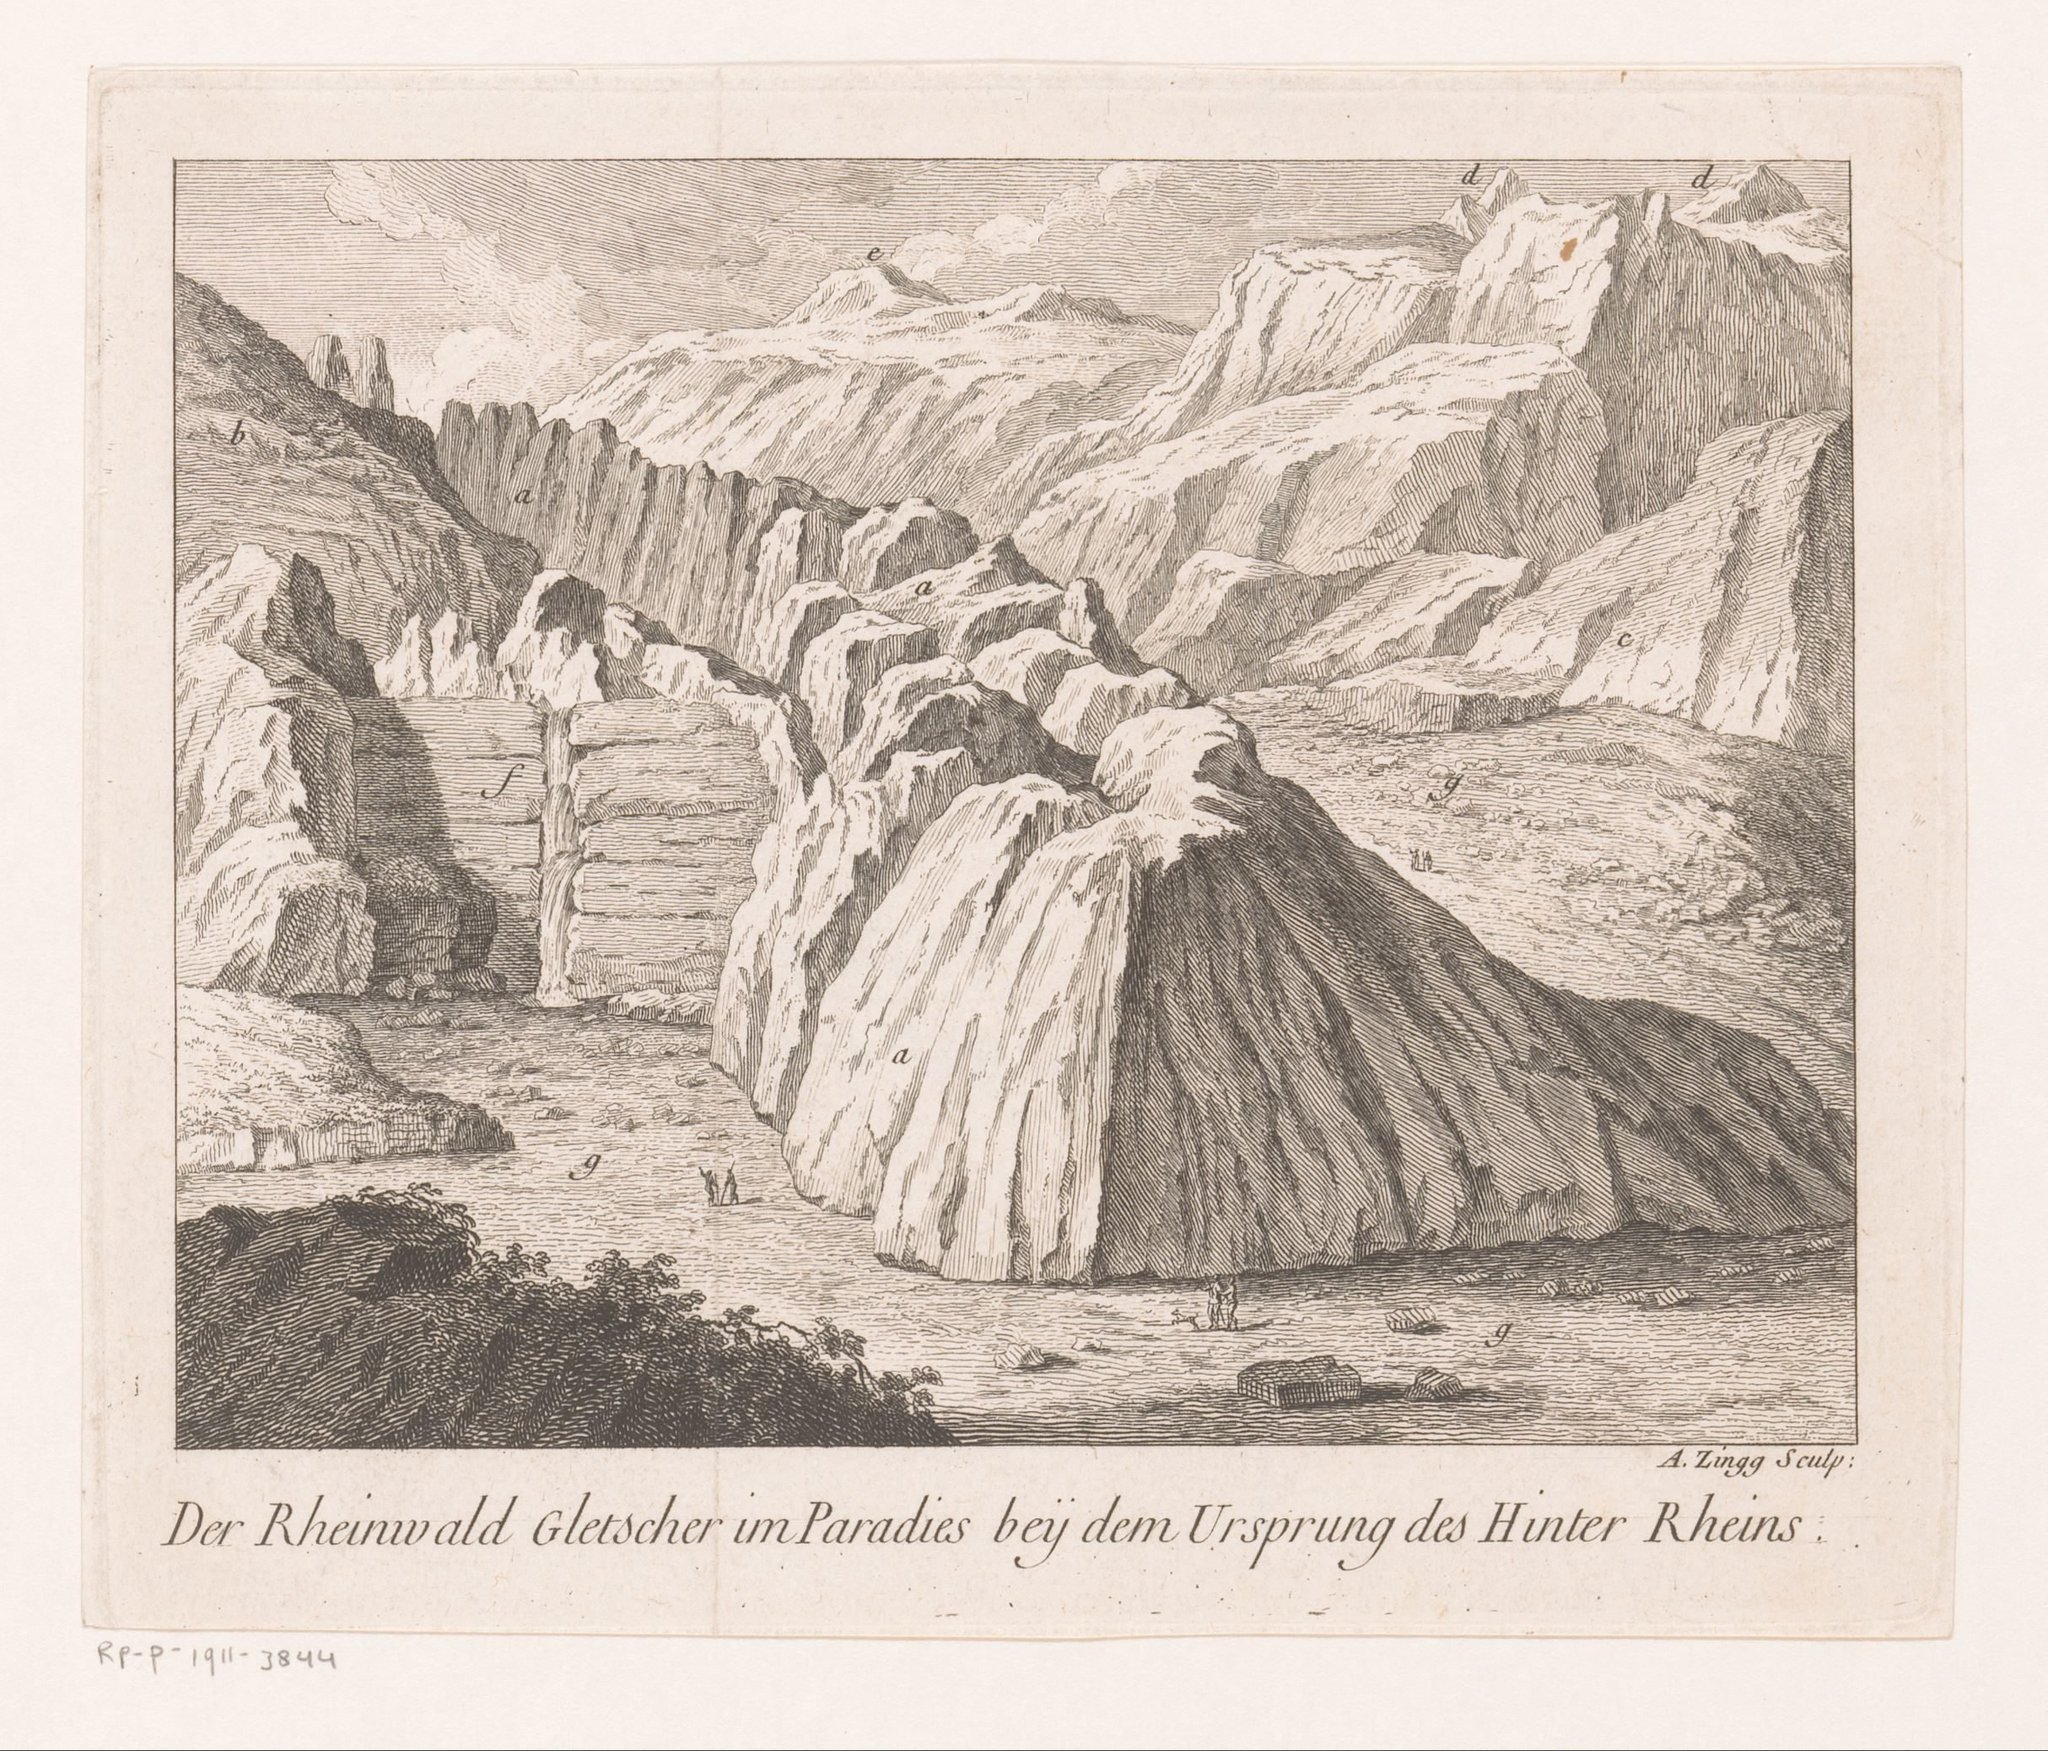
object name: print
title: Gezicht op een gletsjer in de Alpen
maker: adrian zingg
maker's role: draughtsman, print maker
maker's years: 1734-1816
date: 1744-1816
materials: paper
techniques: engraving, etching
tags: landscapes, glacier, mountains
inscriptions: collector's mark: Lugt 2228